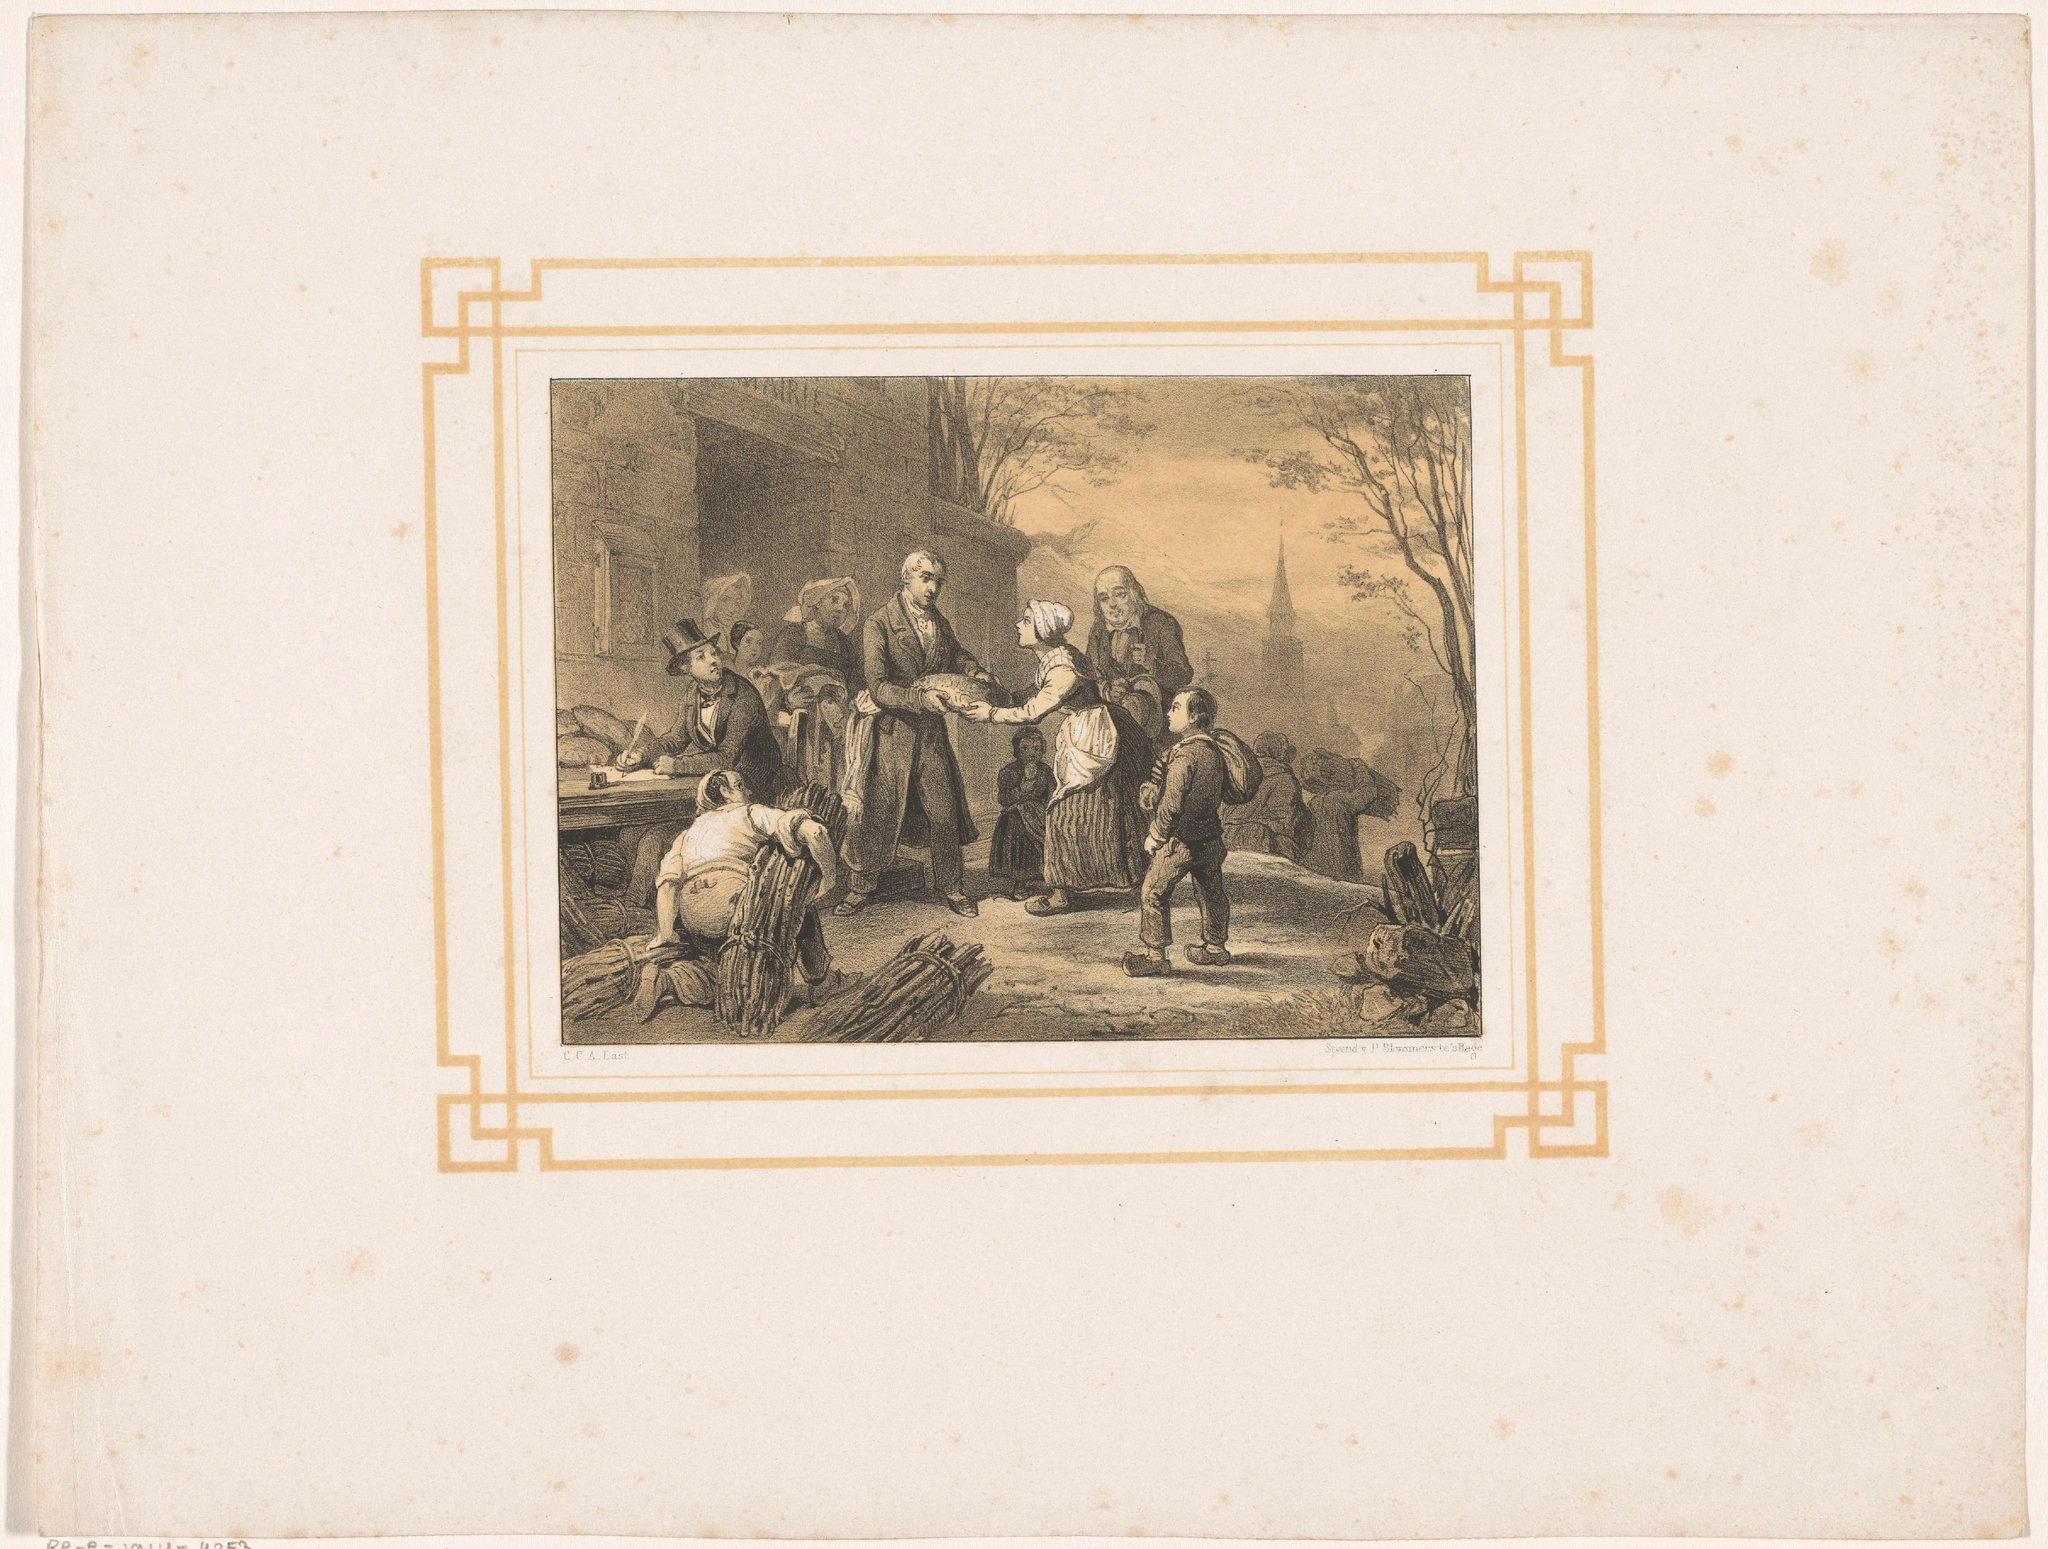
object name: print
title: Brooduitdeling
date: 1843-1876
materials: paper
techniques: tone lithography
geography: the hague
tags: giving alms or other charity, e.g.: handing out food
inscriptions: collector's mark: Lugt 2228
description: Een man deelt brood en hout uit aan de armen.